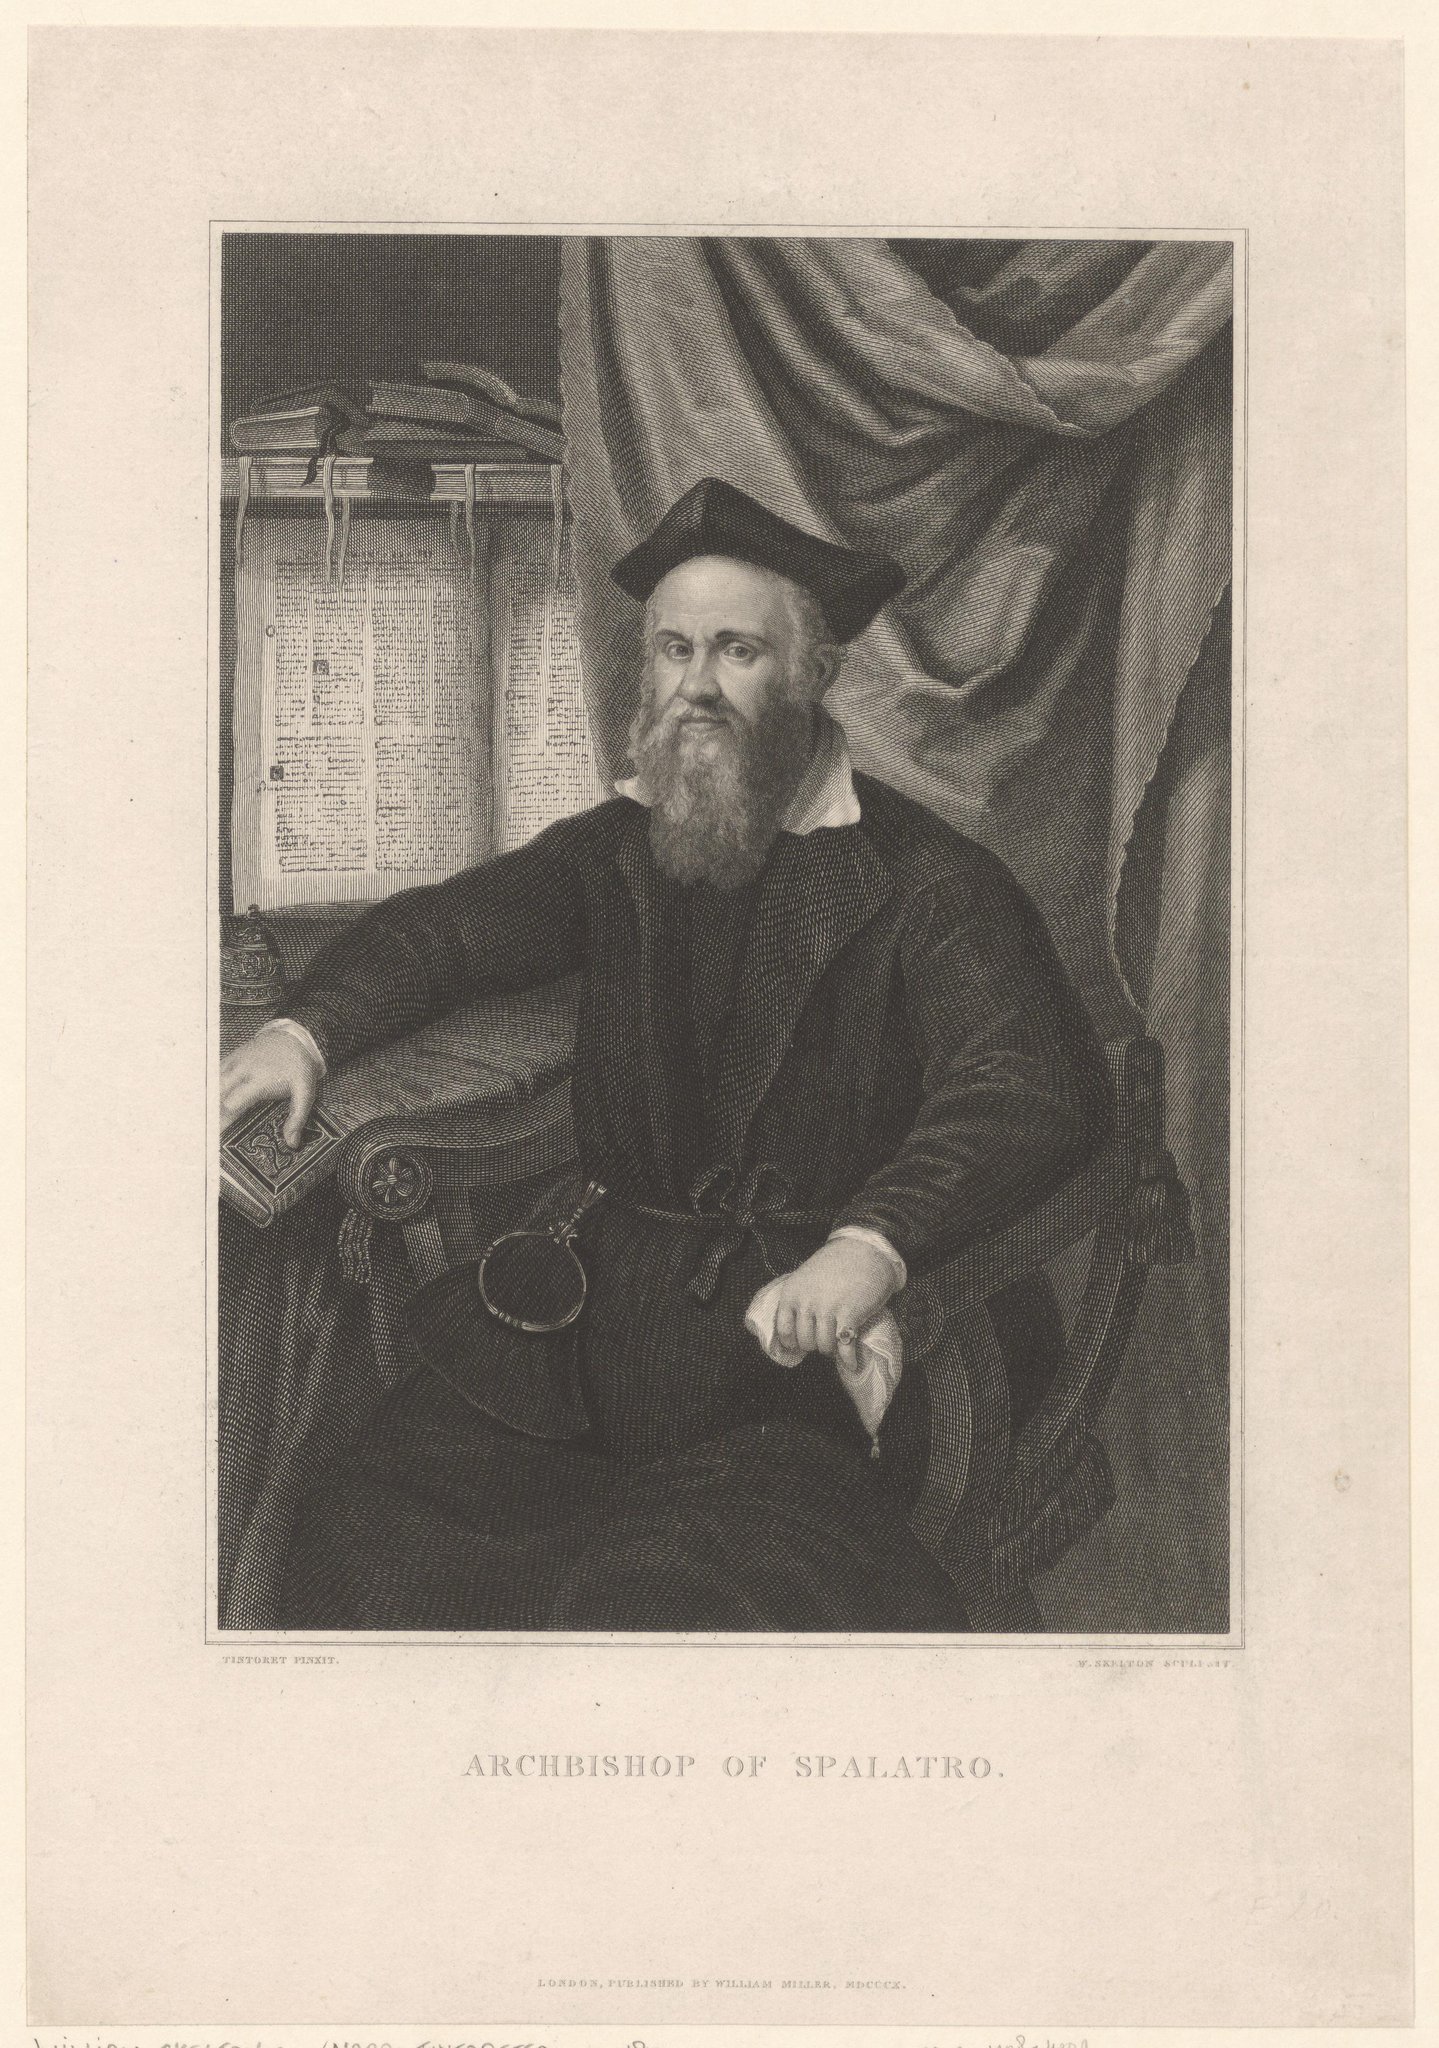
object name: print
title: Archbishop of Spalatro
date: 1810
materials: paper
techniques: engraving, etching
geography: london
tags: archbishop, bishop, etc. (roman catholic), historical persons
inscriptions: collector's mark: Lugt 2228